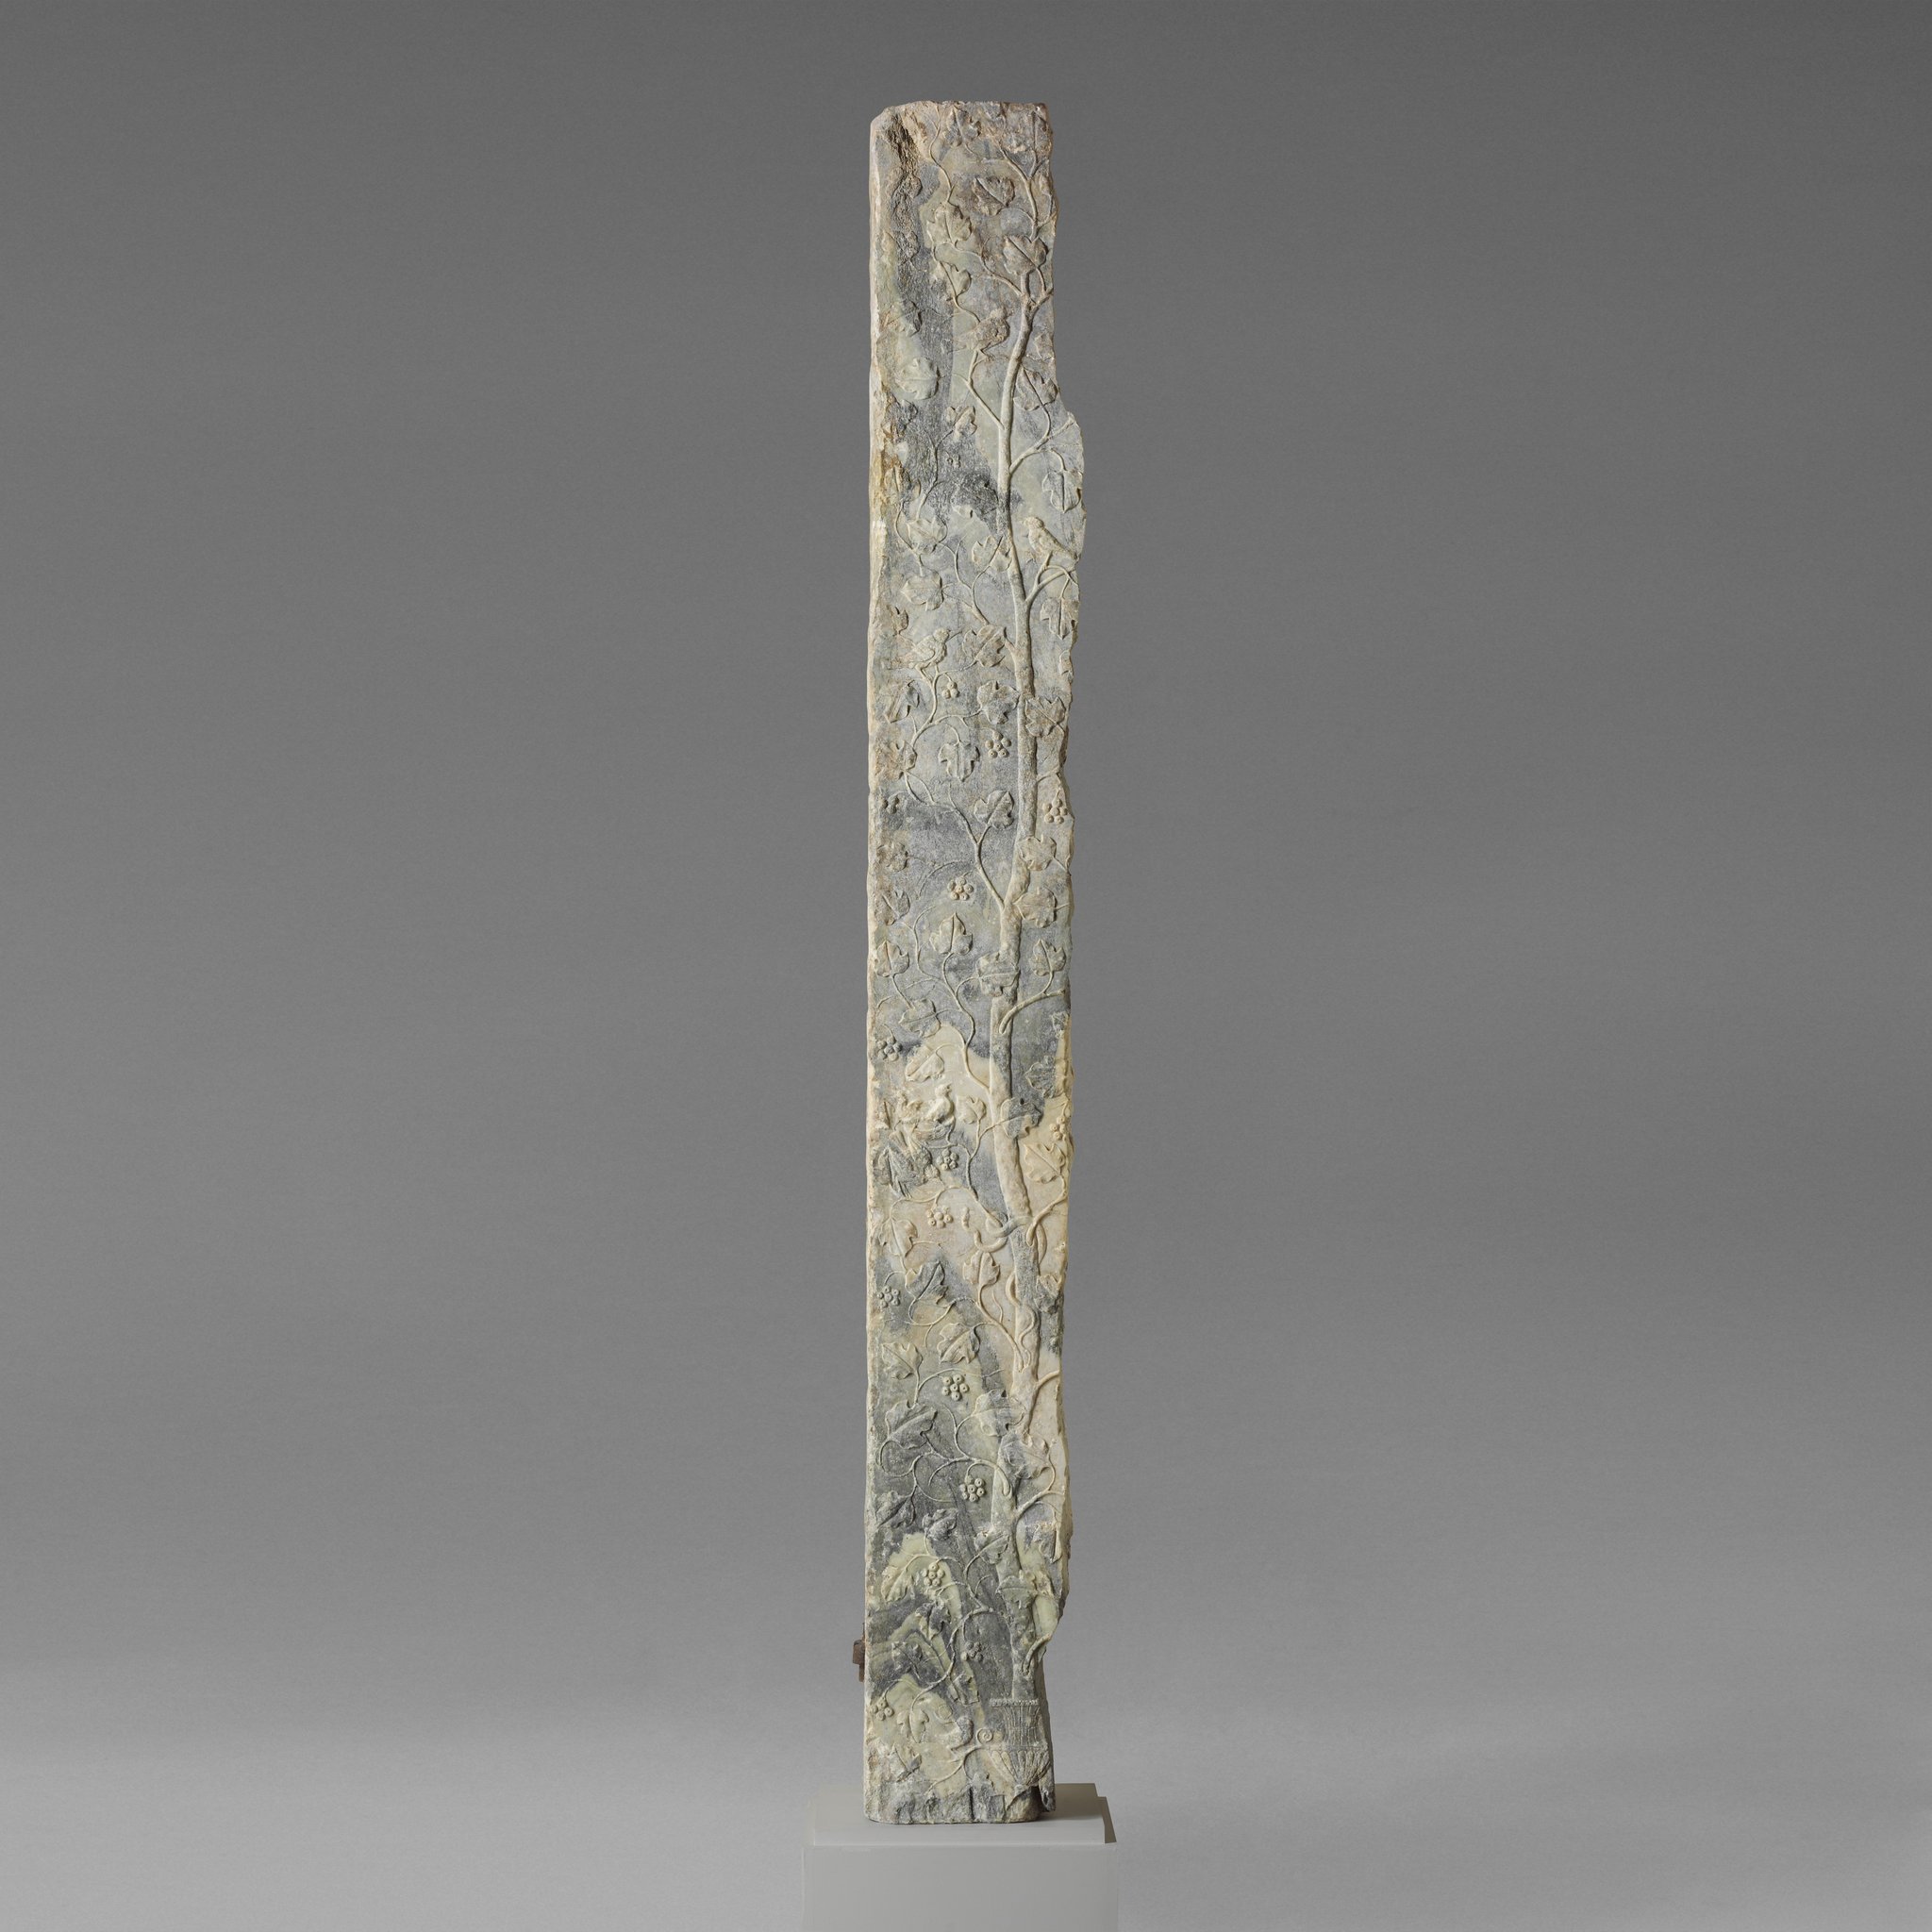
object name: pilaster, 2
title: Two marble pilasters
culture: roman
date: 117-138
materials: marble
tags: vines